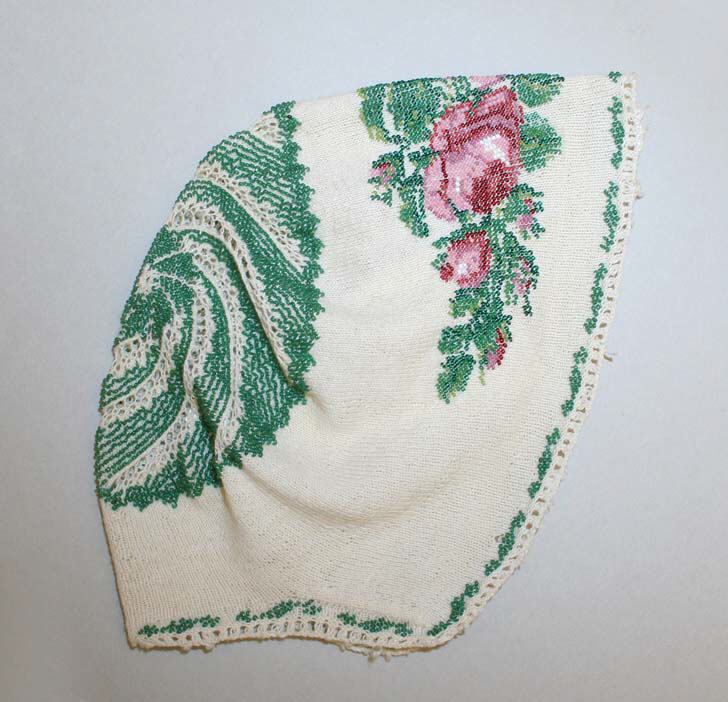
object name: cap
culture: european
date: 1801-1833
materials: cotton, glass